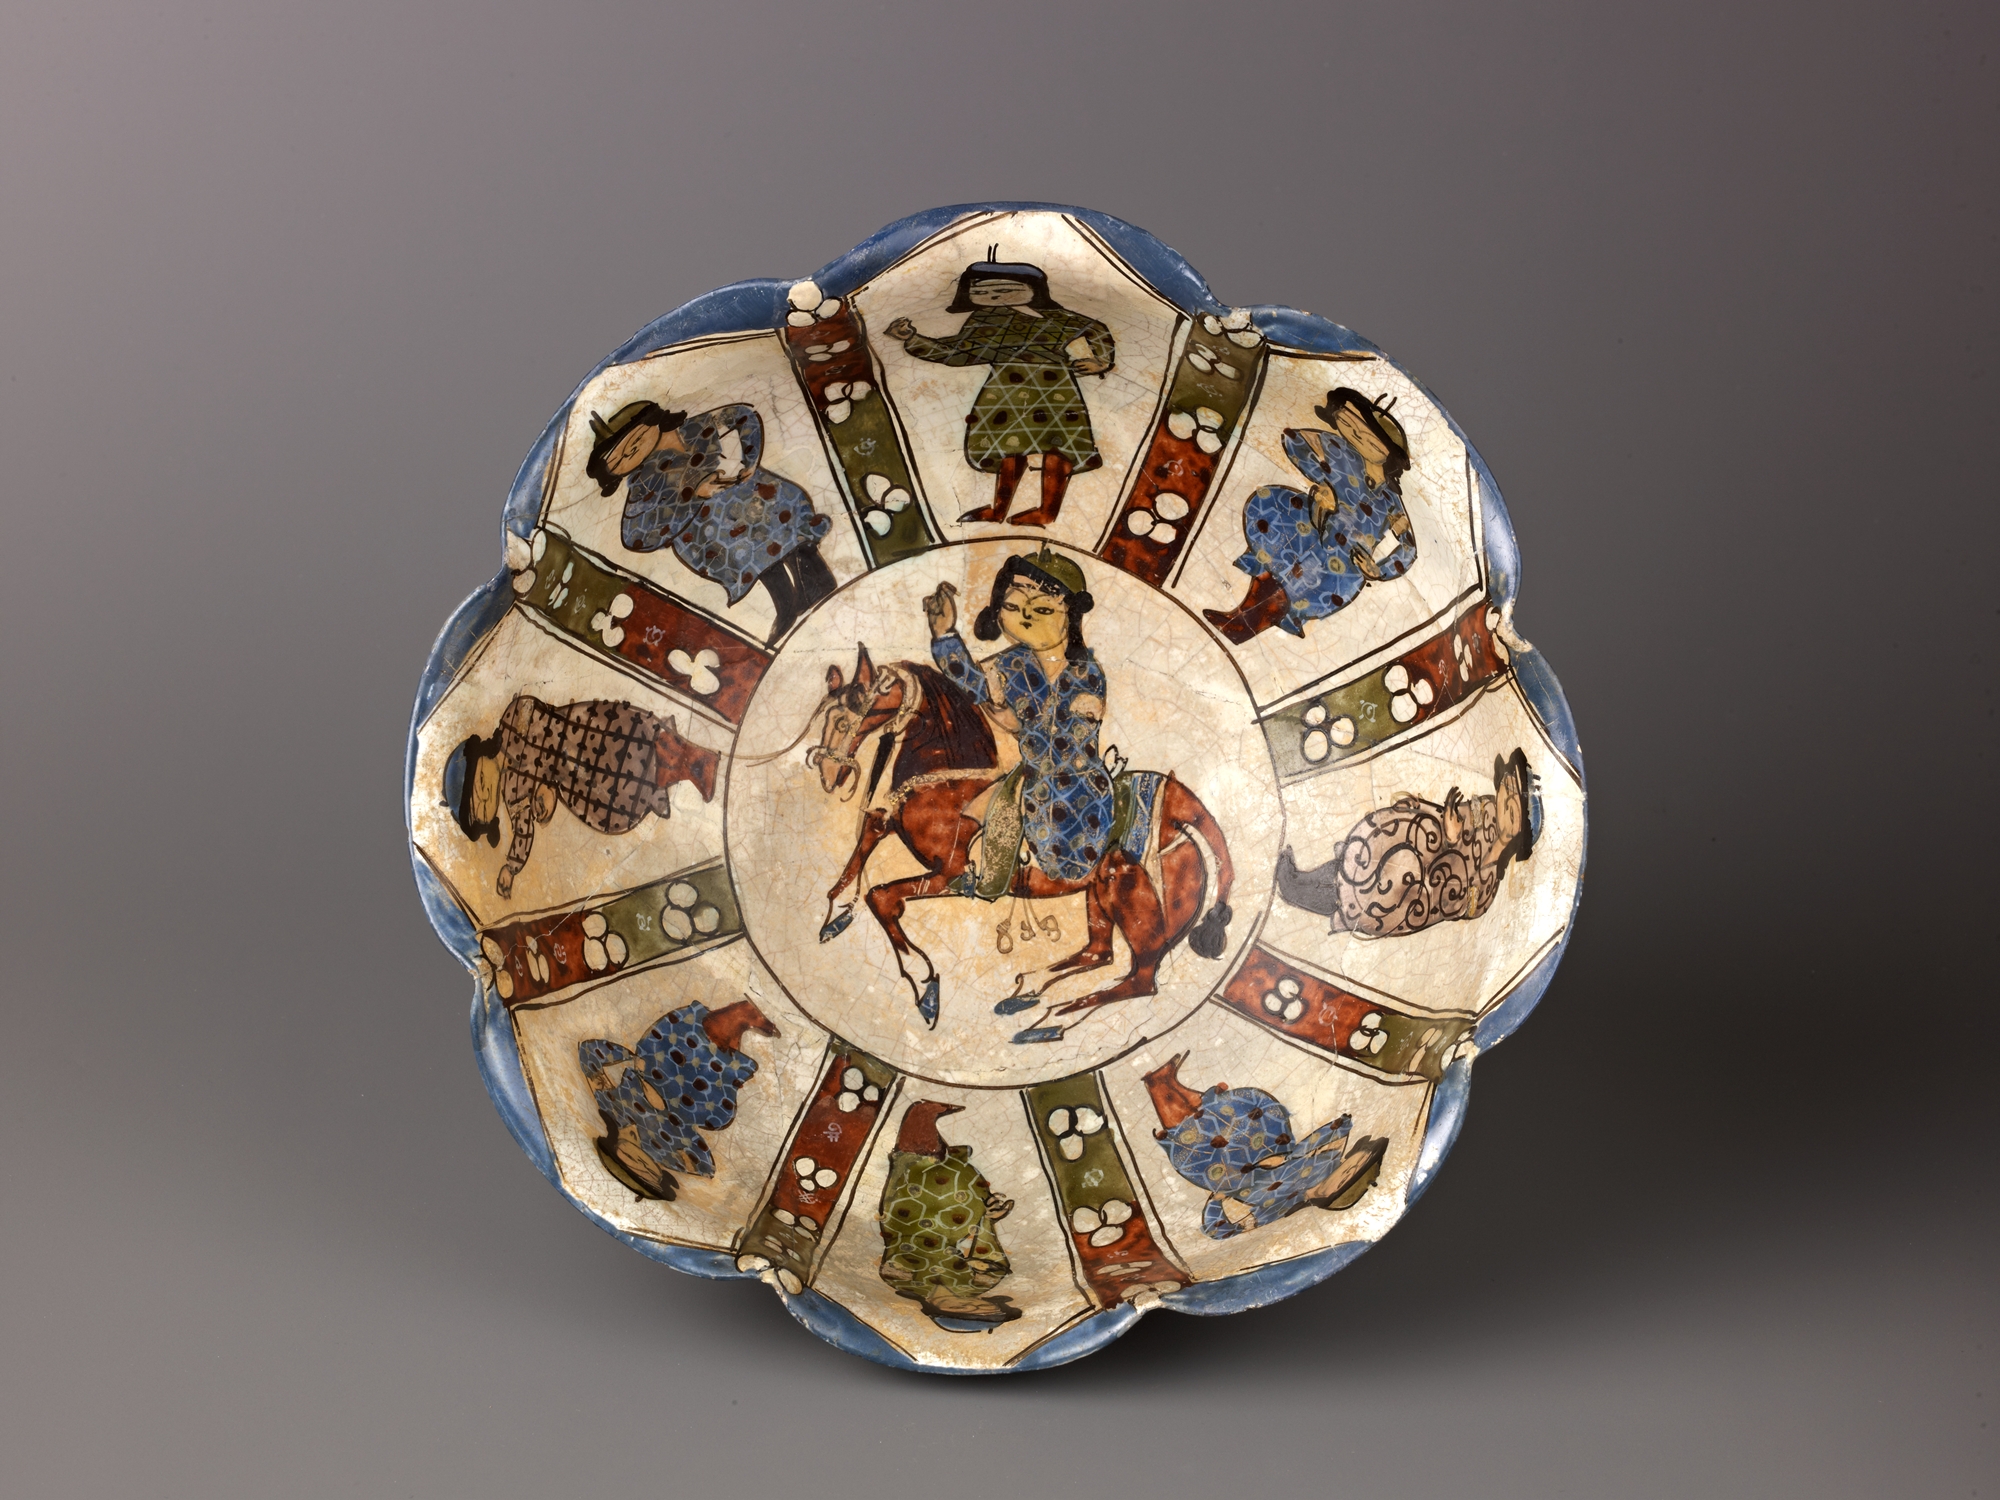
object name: bowl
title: Lobed bowl, Minai'i ("enameled") ware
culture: iranian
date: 1201-1233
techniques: overglaze, painting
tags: men,horses